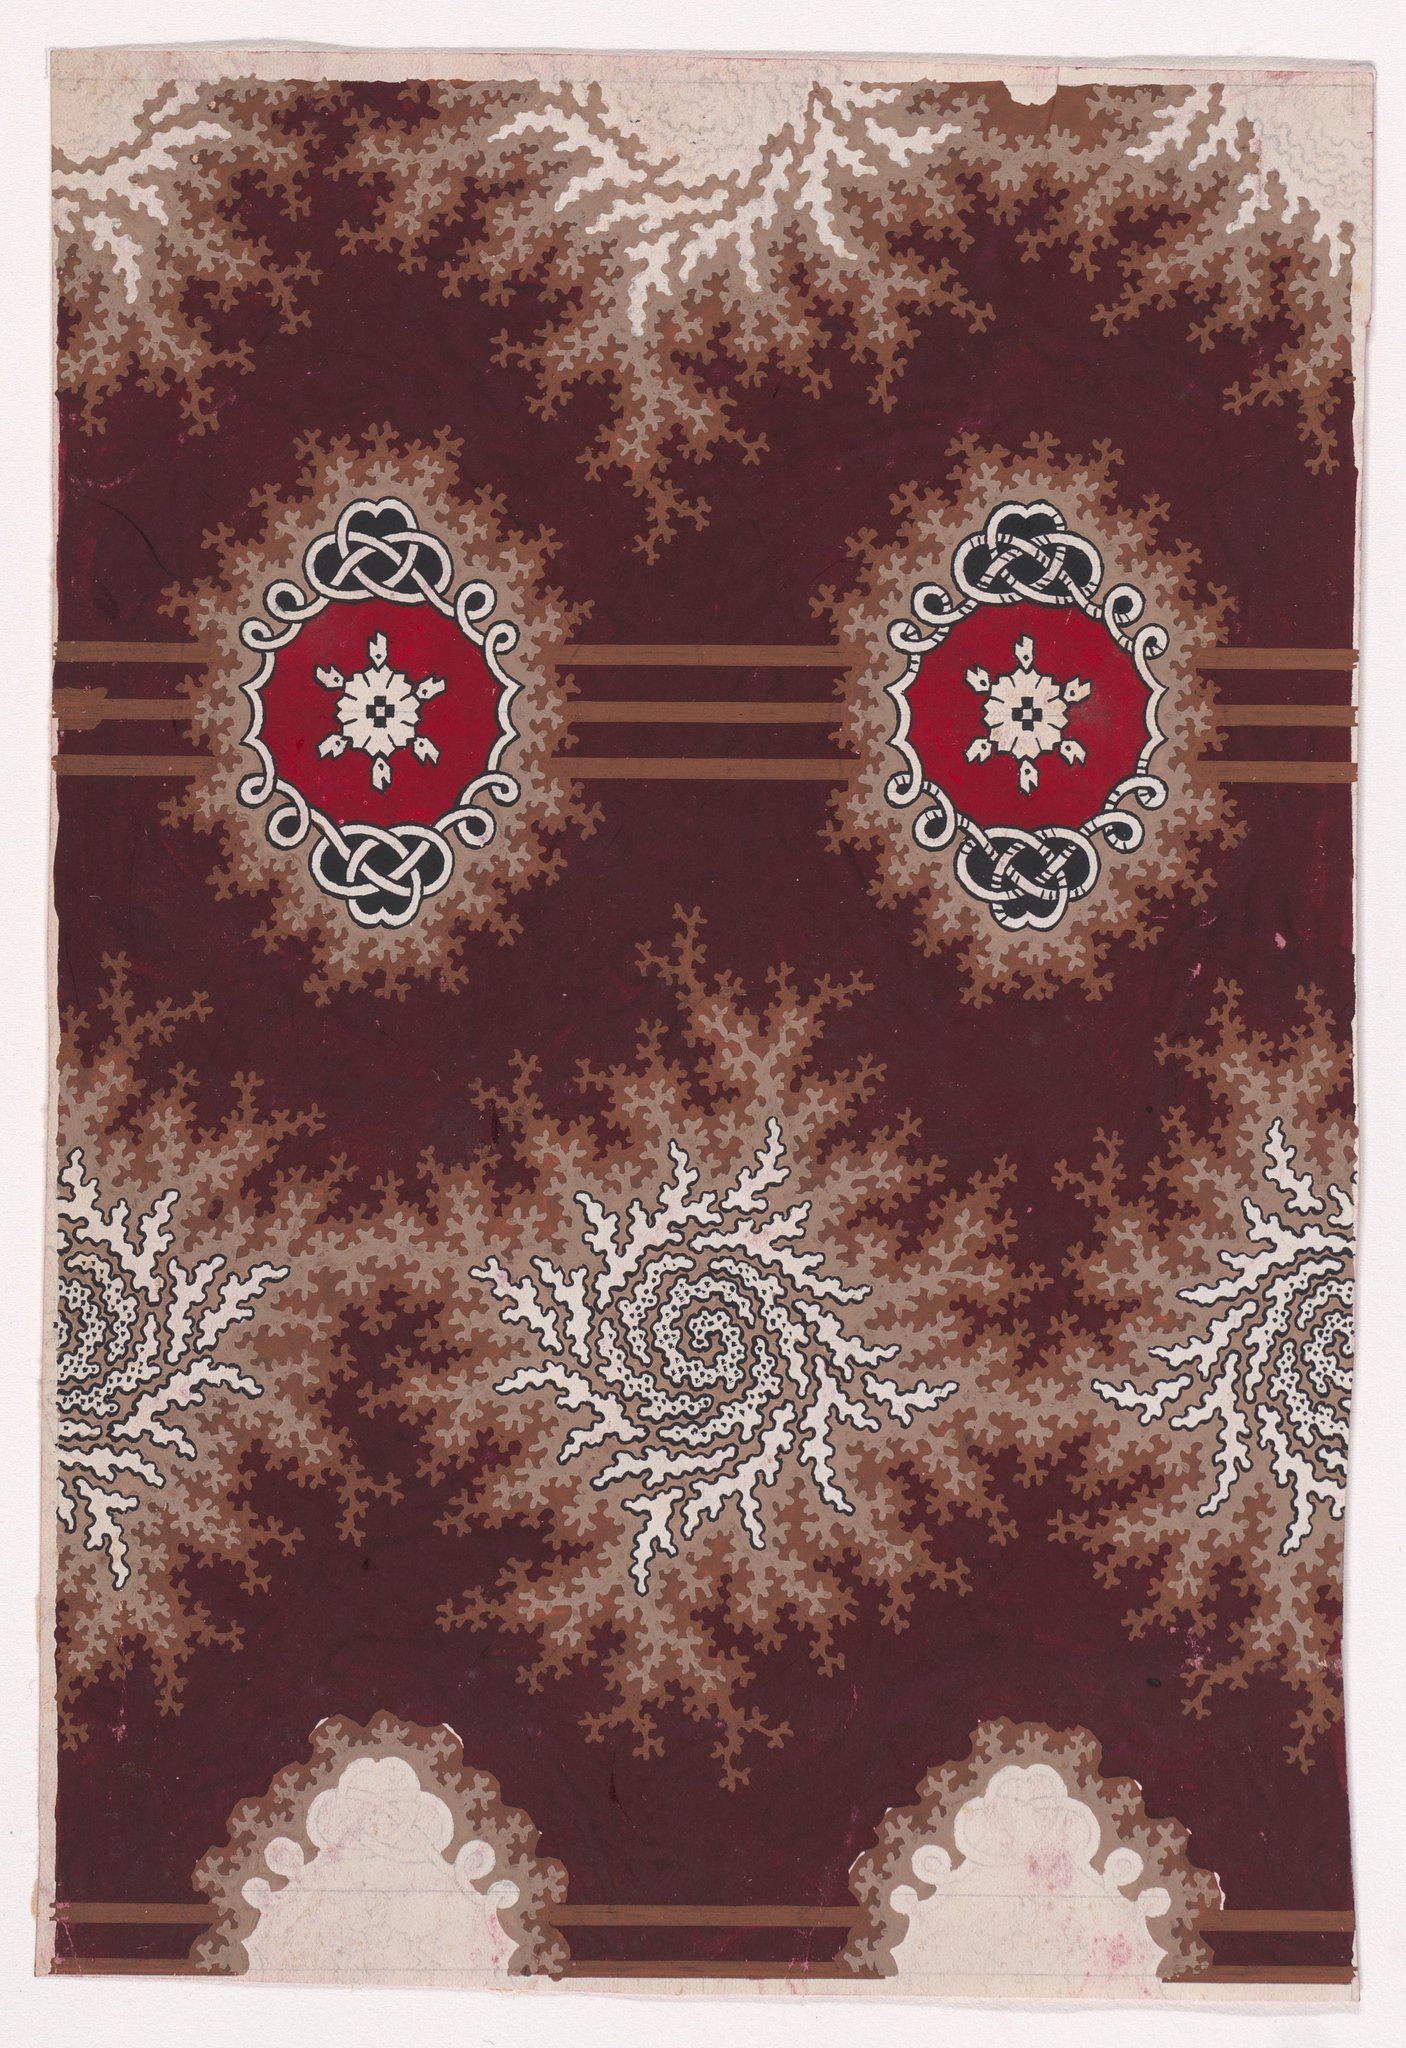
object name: drawing ornament architecture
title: Textile Design with Alternating Horizontal Garlands of Branches with Abstract Swirls and Rosettes Flanked by Stylized Leaves and Framed by an Interlaced Ornamental Motif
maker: anonymous, alsatian, 19th century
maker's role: artist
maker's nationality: alsatian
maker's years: 1800-1900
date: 1840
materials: gouache